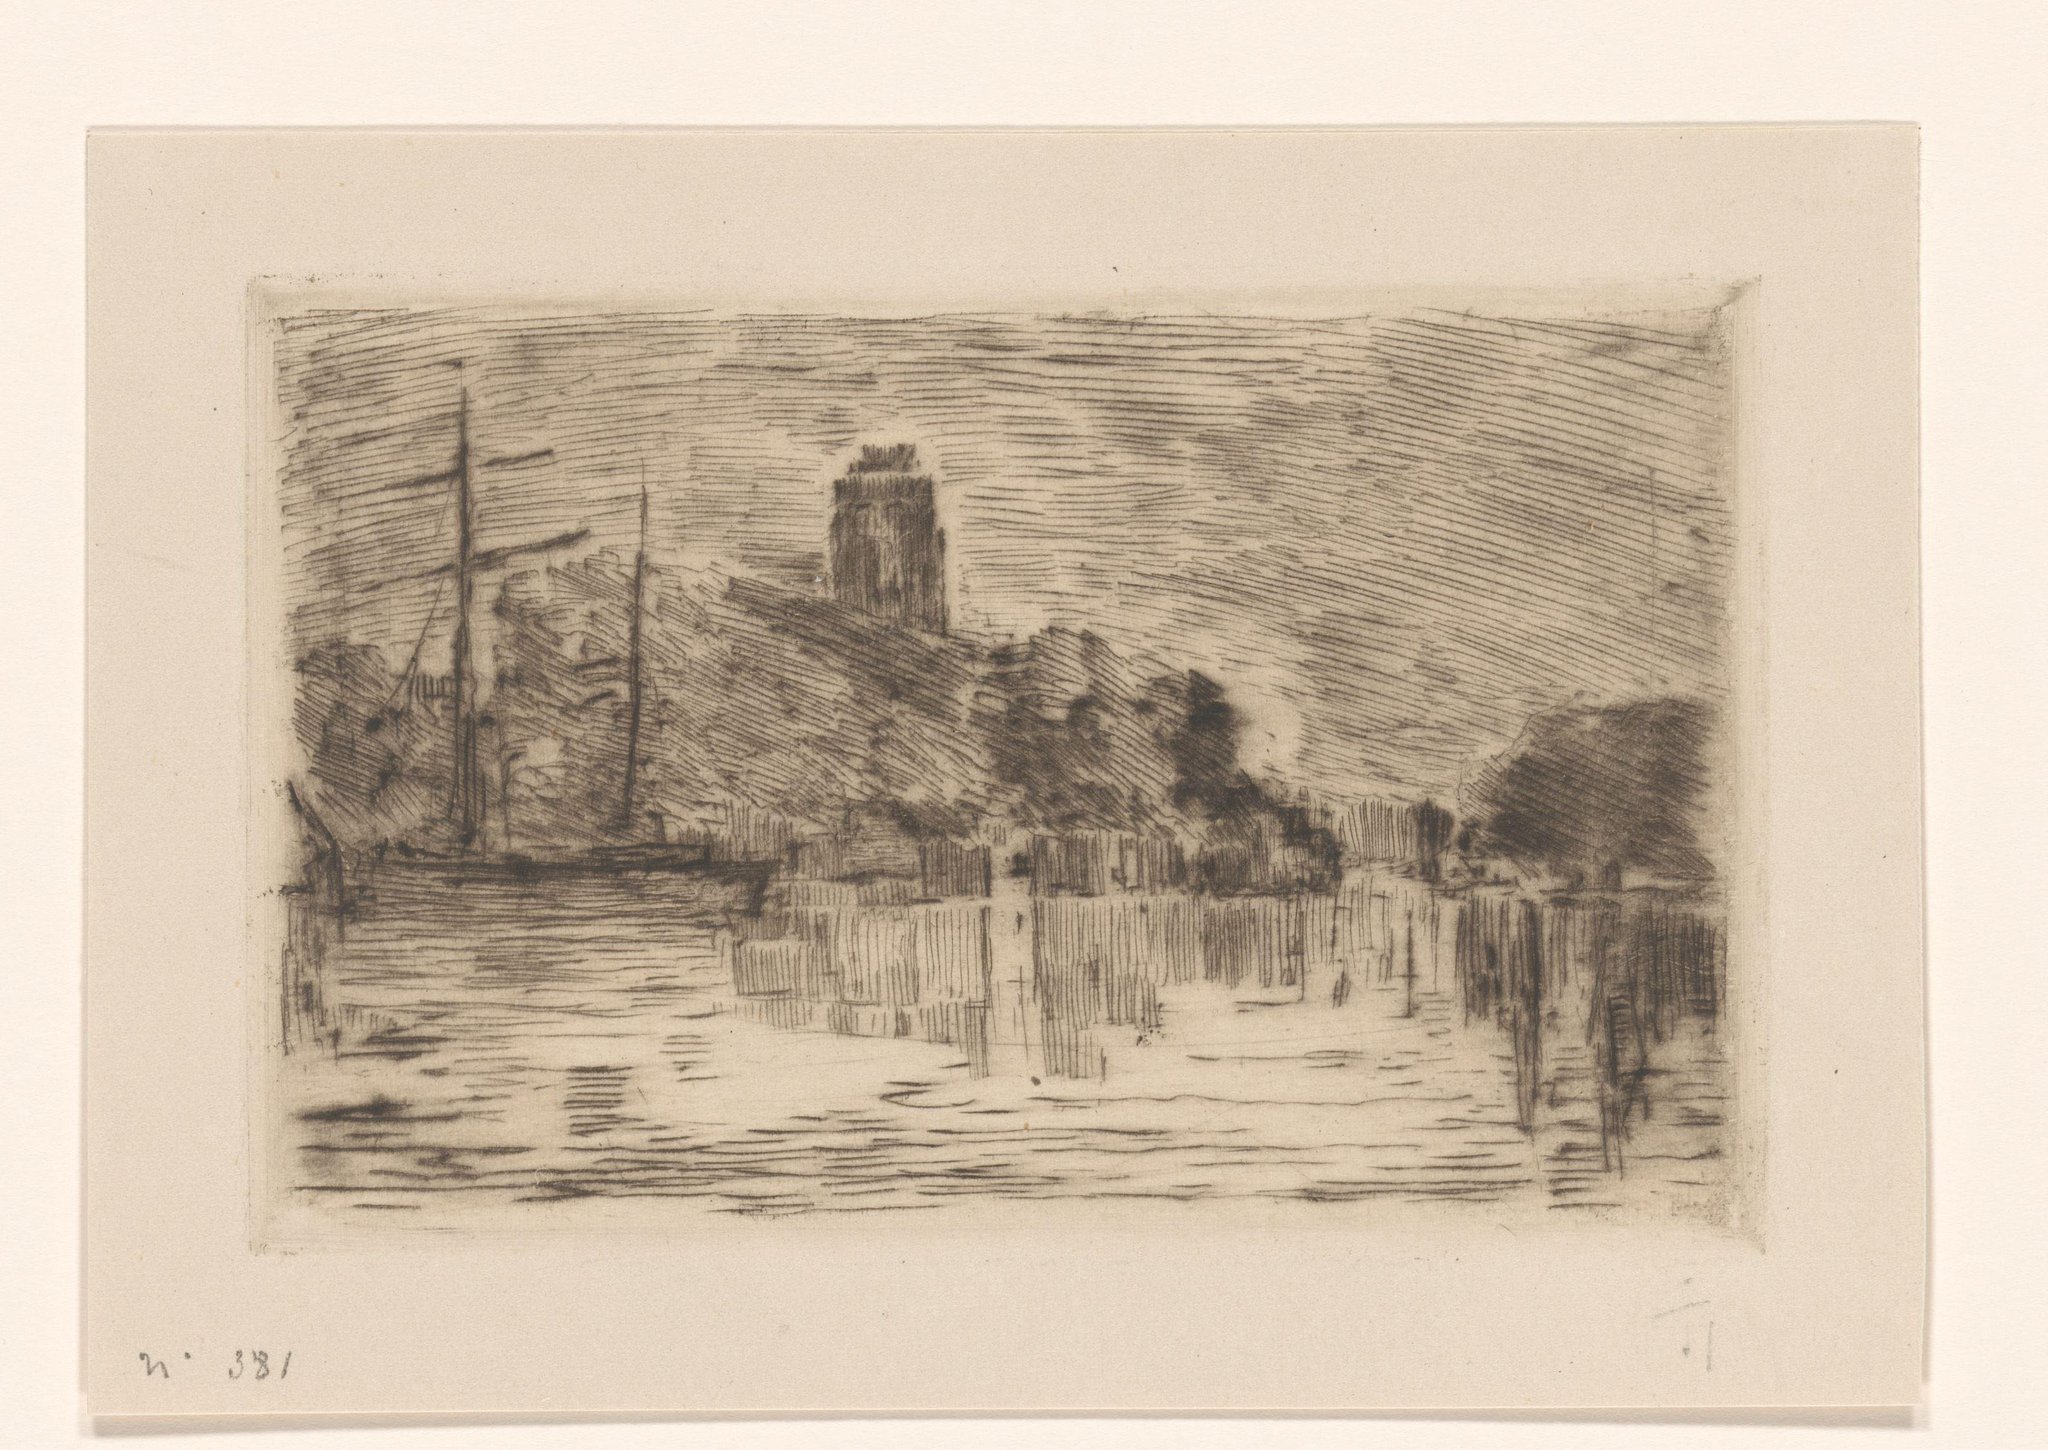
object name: print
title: Gezicht op de Nieuwe Haven in Dordrecht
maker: carel nicolaas storm van s-gravesande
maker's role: draughtsman, print maker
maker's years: 1841-1924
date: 1851-1902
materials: paper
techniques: drypoint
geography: netherlands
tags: harbour, parts of church exterior and annexes: tower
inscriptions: collector's mark: Lugt 2228, inscription: ‘Dordrecht’, number: ‘381’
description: Mogelijk vermeld in: Storm van 's-Gravesande, Charles. Catalogue des eaux-fortes et lithographies. New York: s.n., 1903, of in een onbekende latere uitgave van het manuscript. Vermoedelijk vermeld als catalogusnummer 381.